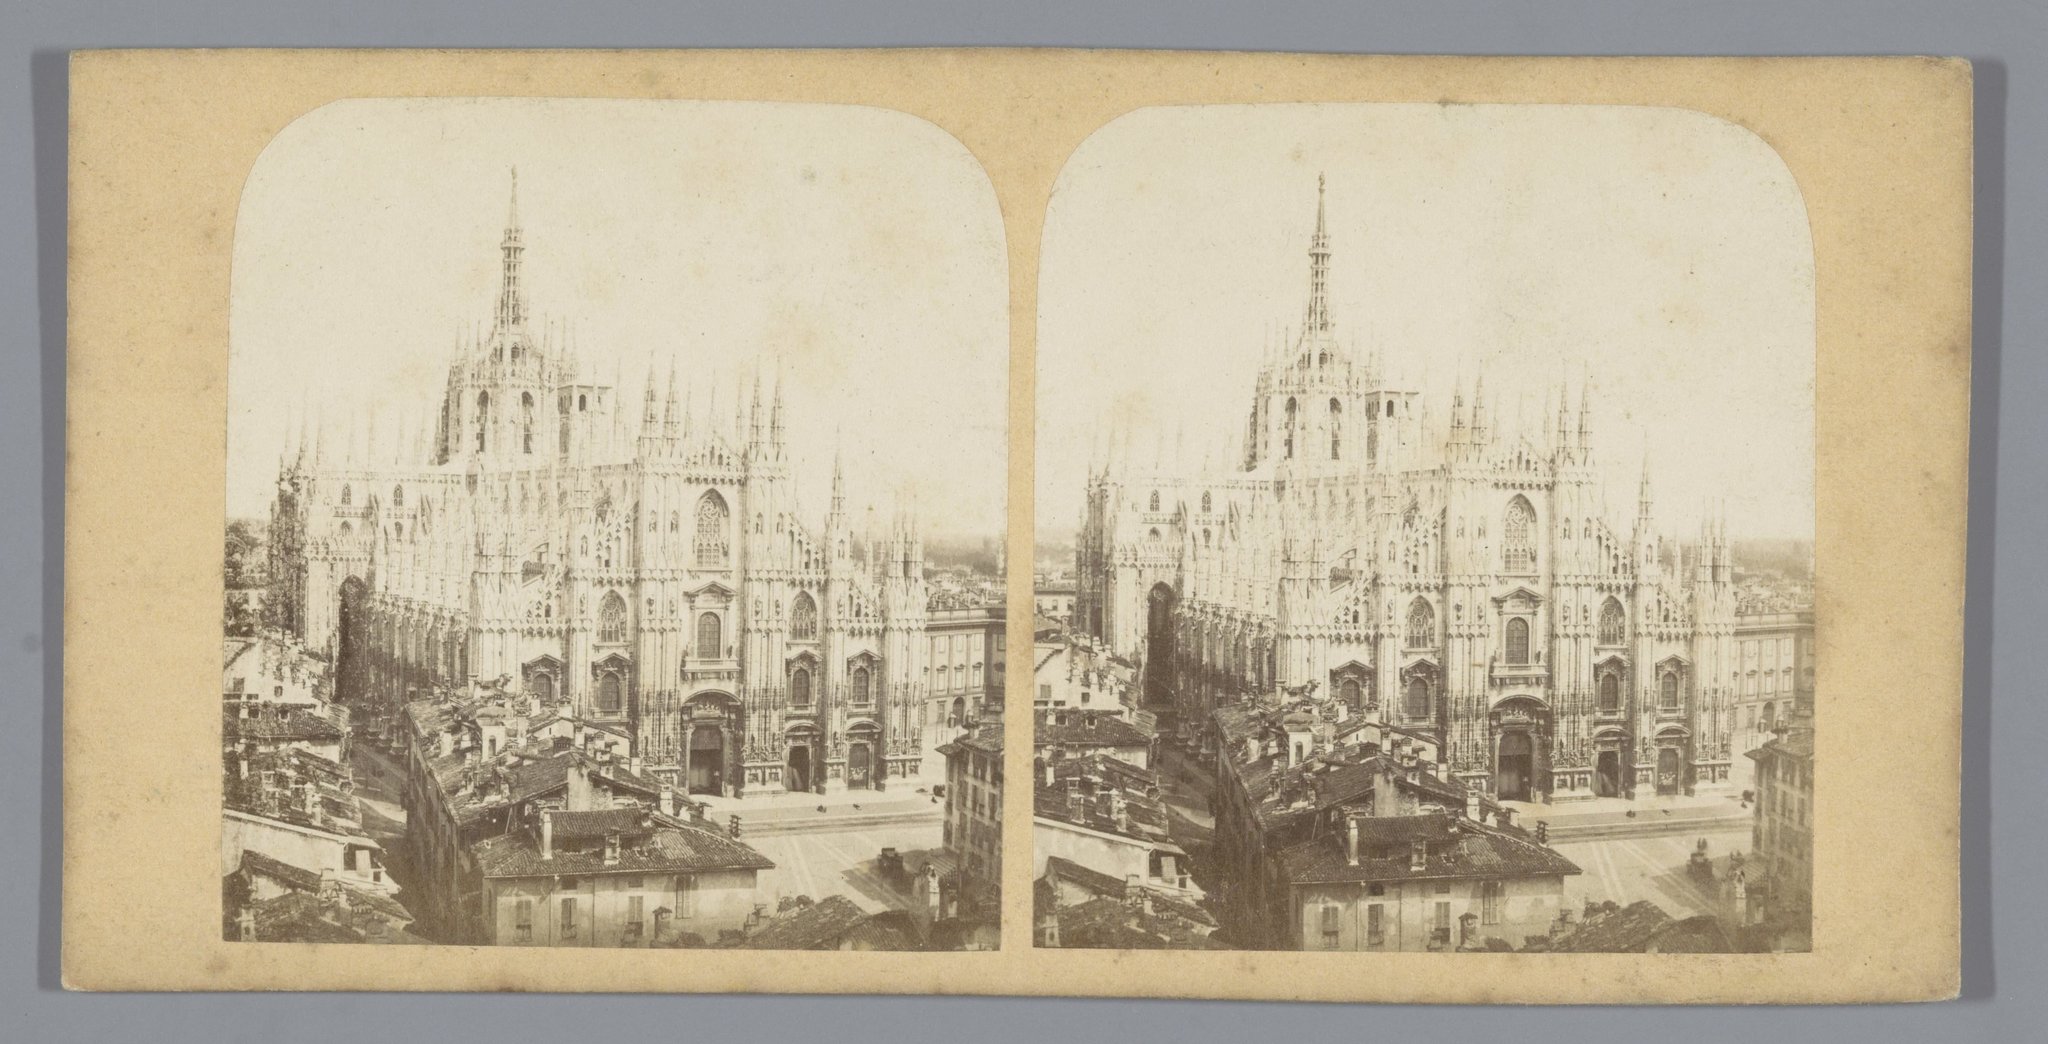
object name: stereograph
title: Gezicht op de Dom van Milaan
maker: Anonymous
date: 1850-1880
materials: cardboard, photographic support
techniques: albumen print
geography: milan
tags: church (exterior), façade (of house or building)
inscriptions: inscription: ‘Cathédrale de Milan.’, number: ‘No 7200’